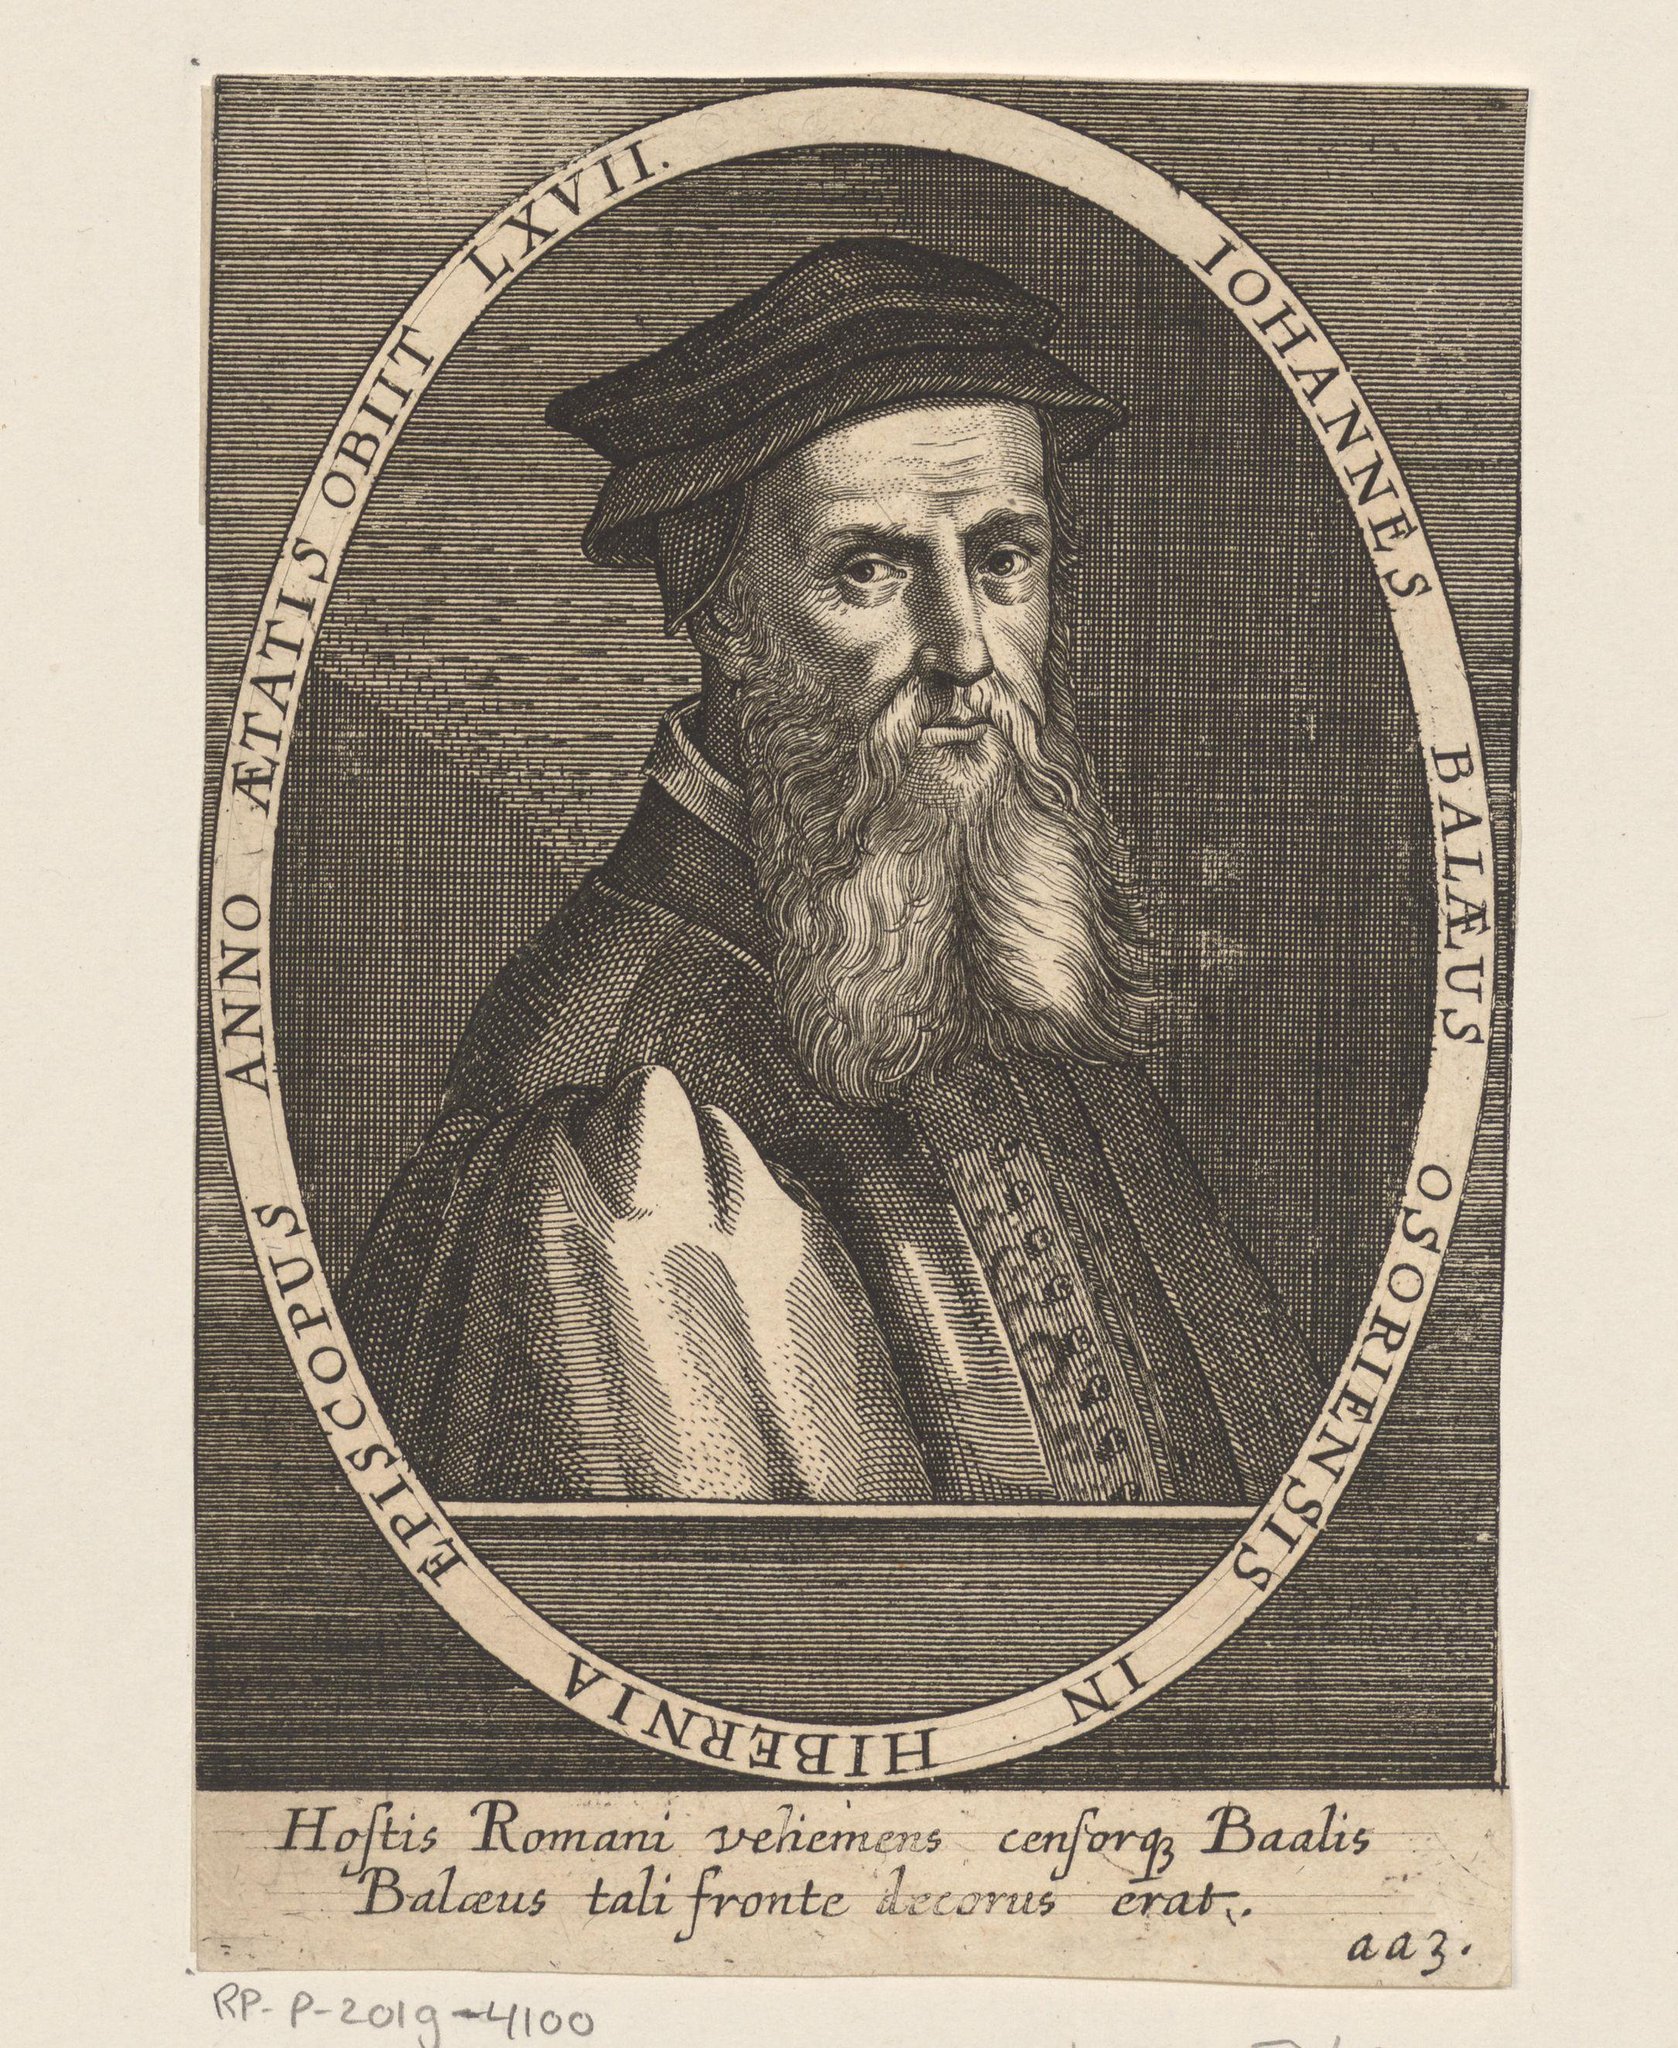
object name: book illustration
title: Portret van John Bale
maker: clemens ammon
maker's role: print maker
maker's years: 1627-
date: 1669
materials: paper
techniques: engraving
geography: frankfurt am main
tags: historical persons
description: Prent uit: Boissard, Jean-Jacques. Bibliotheca chalcographica. Frankfurt am Main: Clemens Ammon, 1669, dl. 7.